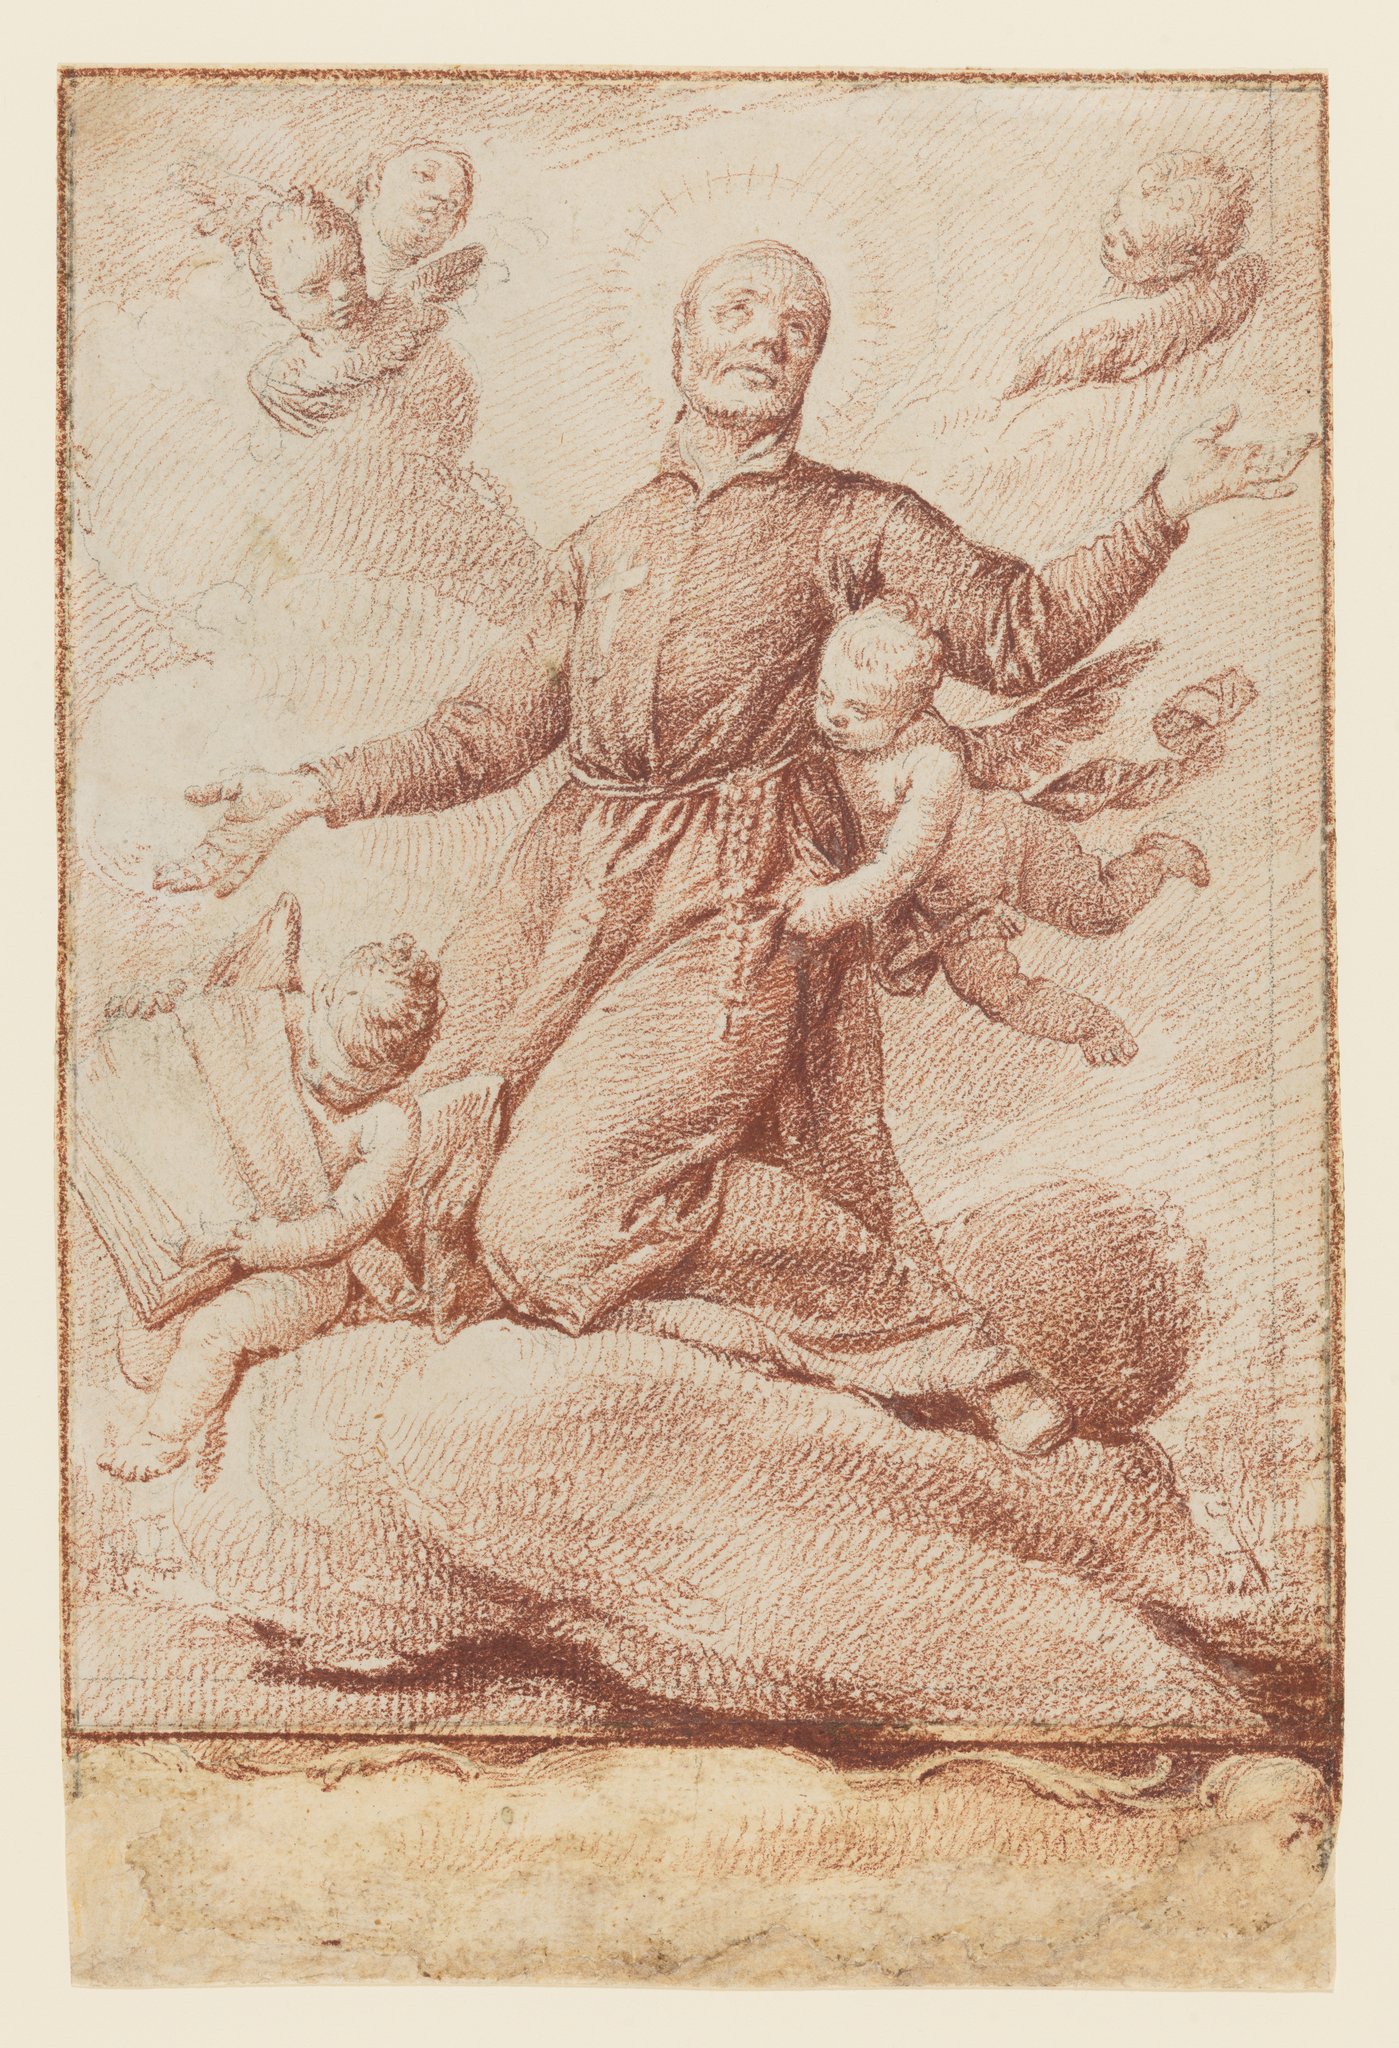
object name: drawing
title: Saint Ignatius with Putti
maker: anonymous, italian, 18th century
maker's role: artist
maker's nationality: italian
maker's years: 1700-1800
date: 1701-1800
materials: chalk